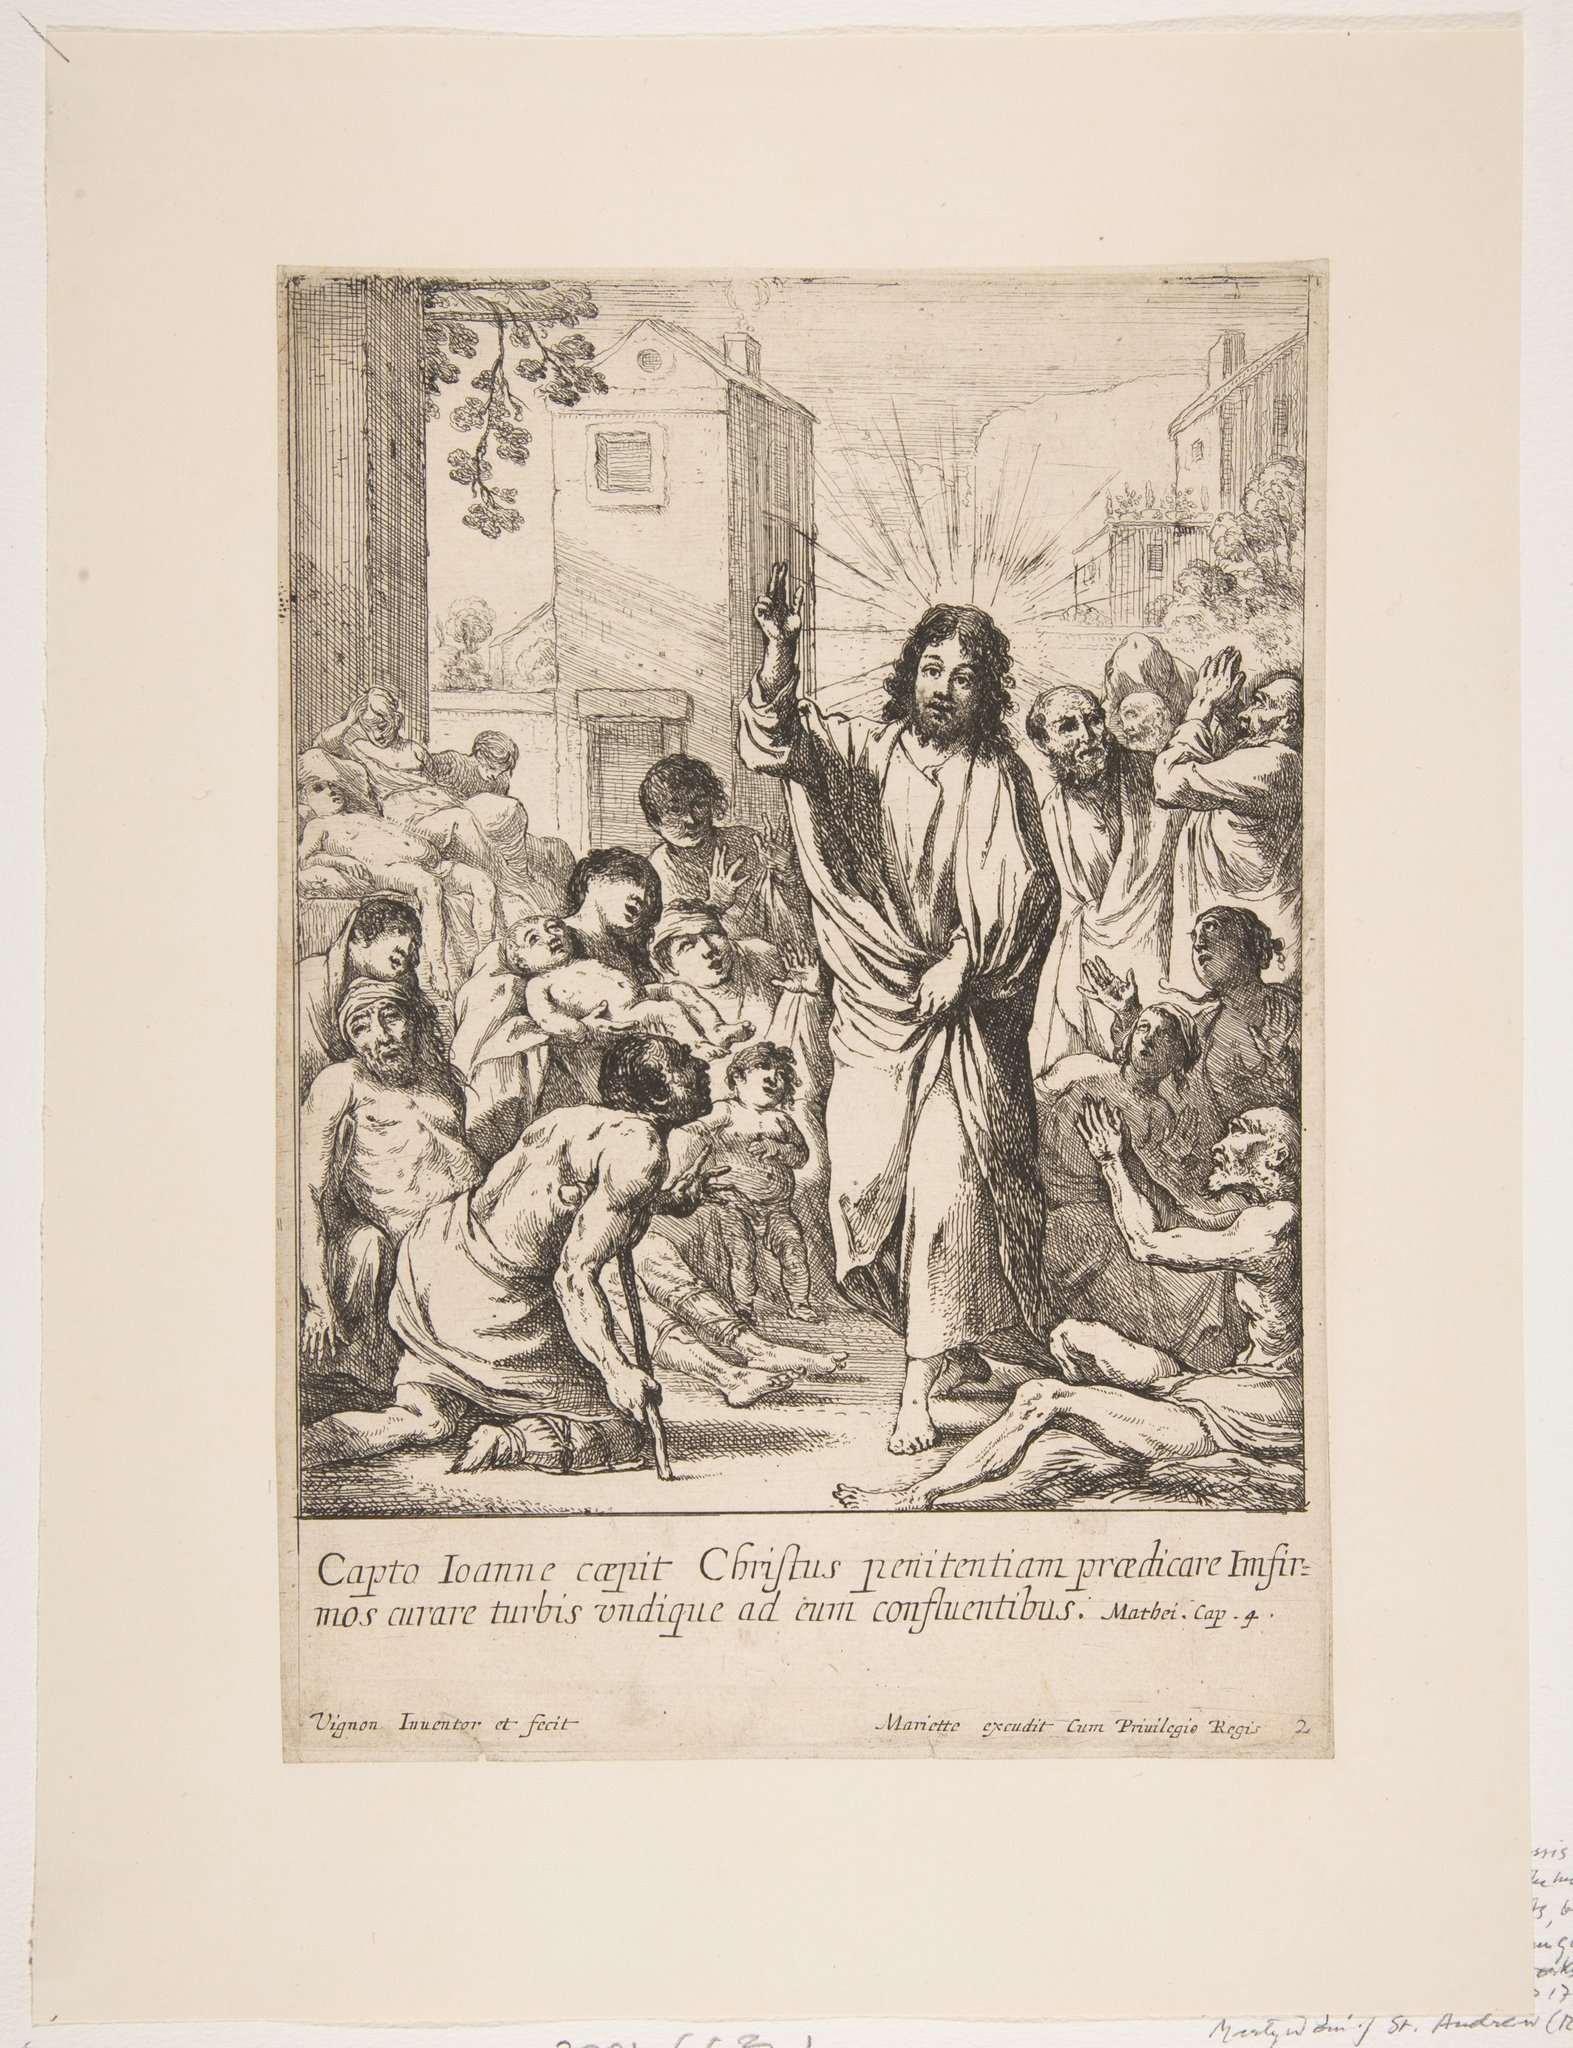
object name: print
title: Healing the Infirm (Jésus-Christ guérit plusieurs malades en Galilée)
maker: claude vignon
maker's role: artist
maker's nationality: french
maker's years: 1593-1670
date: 1593-1670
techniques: etching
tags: illness,infants,men,women,jesus